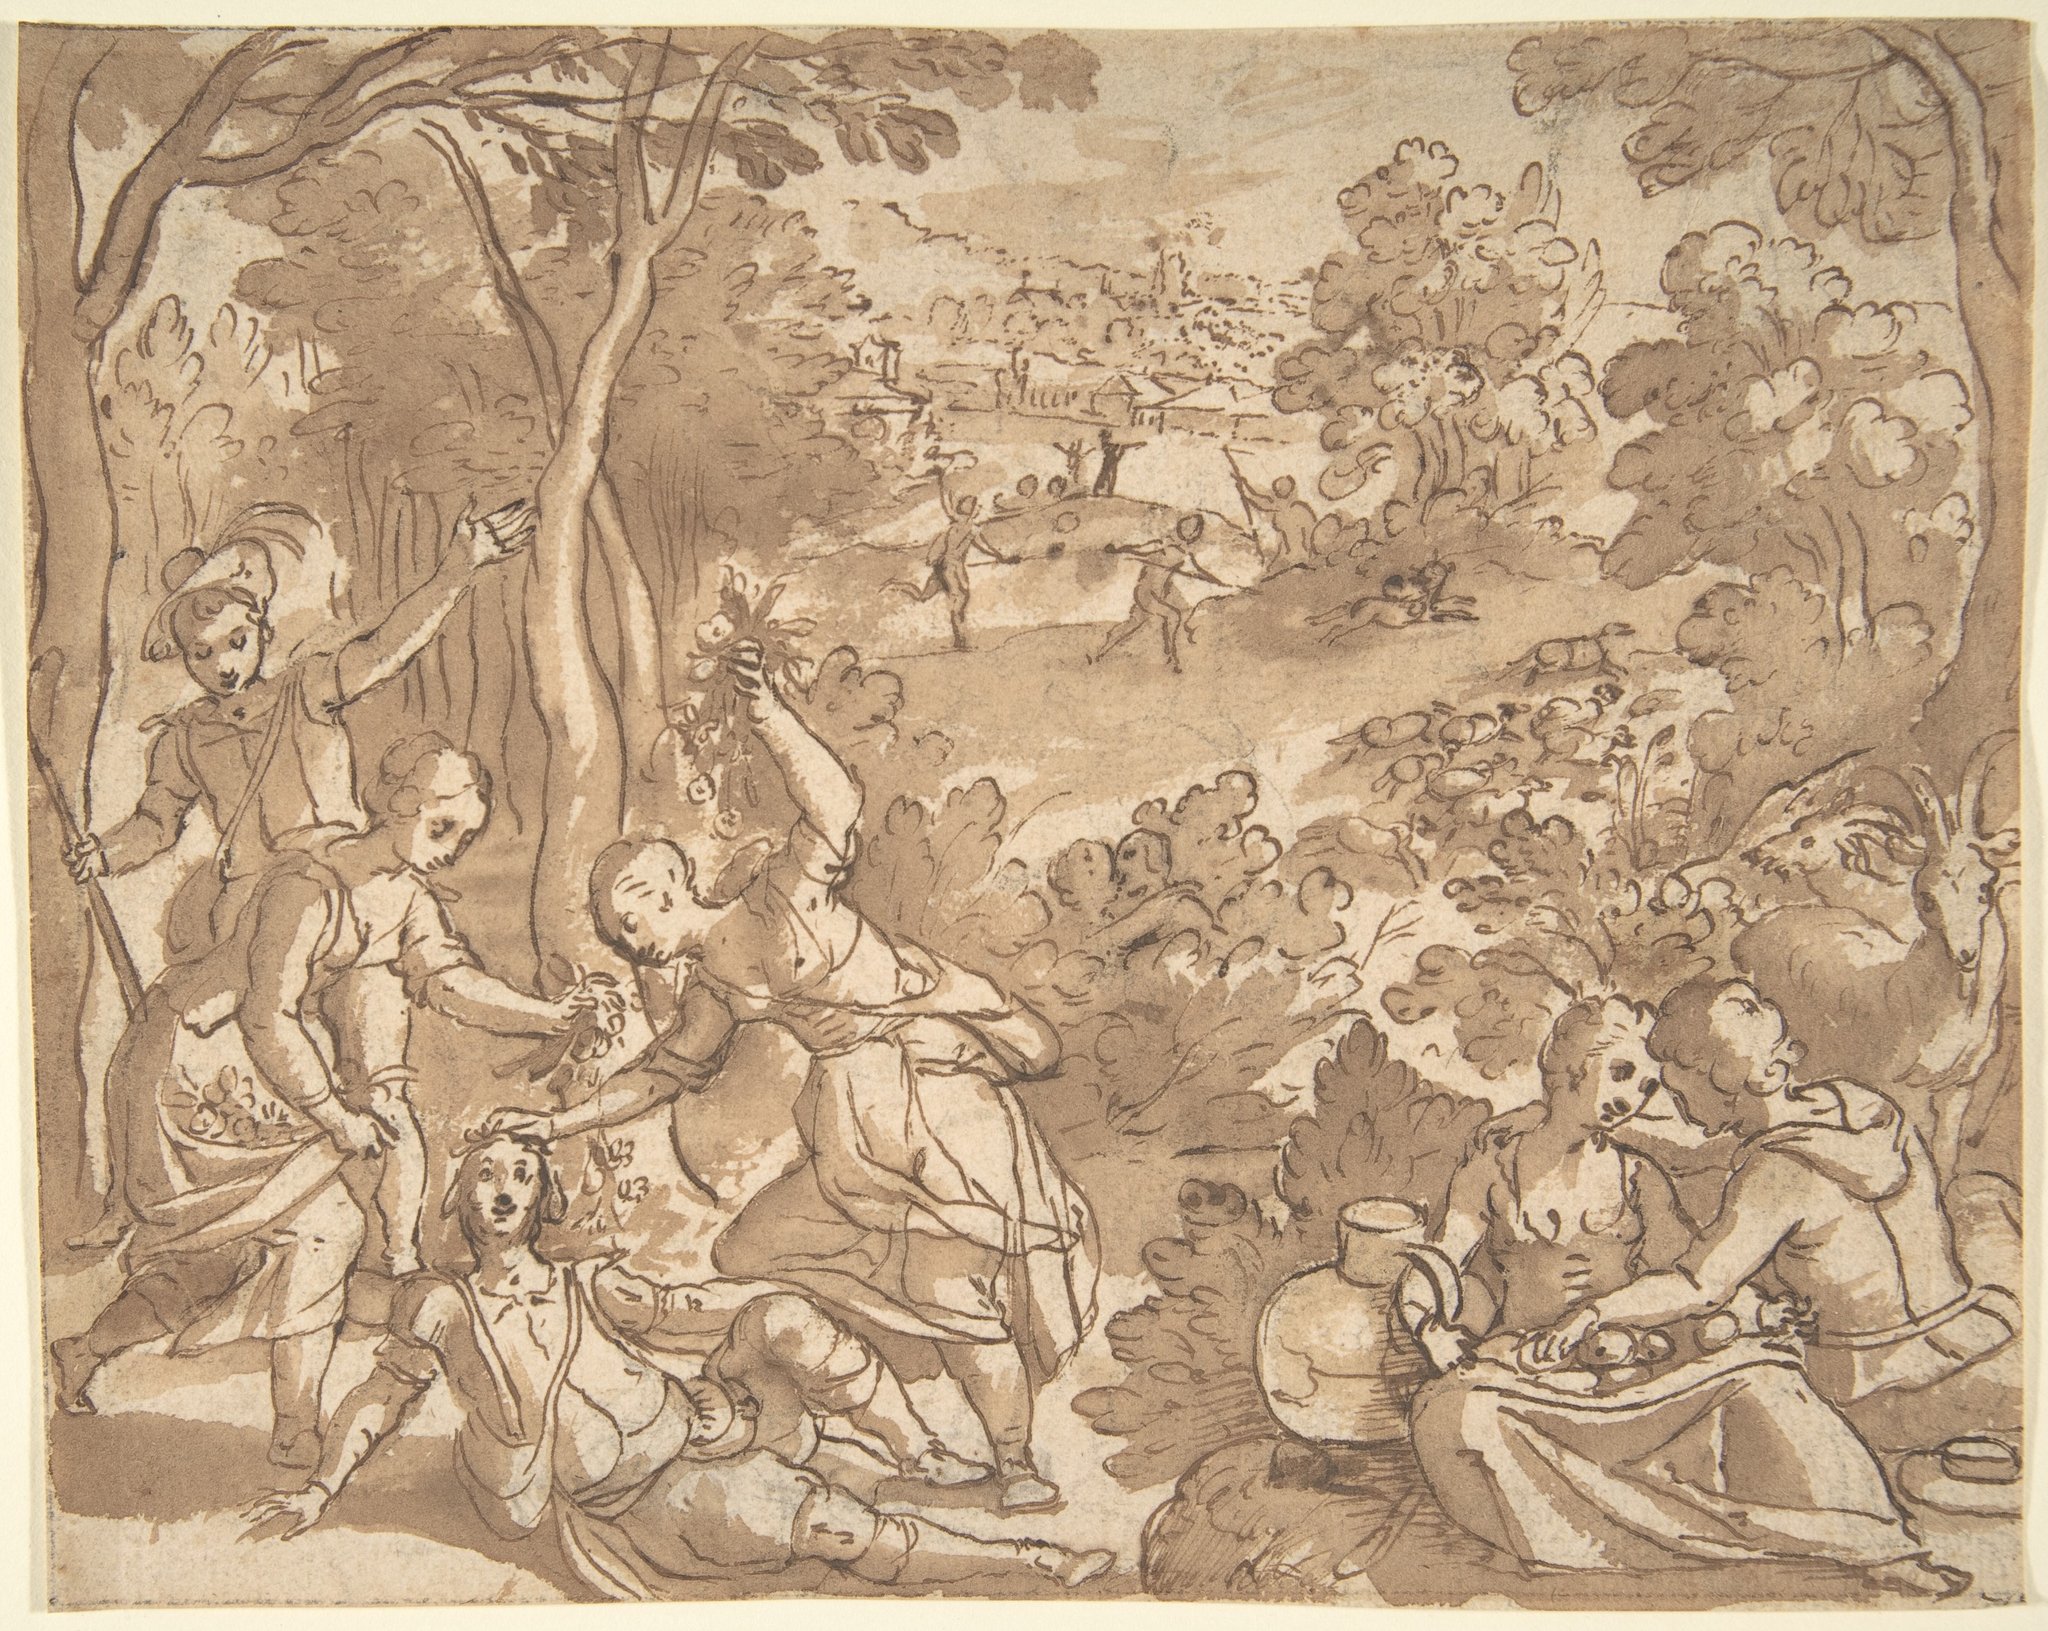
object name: drawing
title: Landscape with Lovers and Hunters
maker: adam van noort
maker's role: artist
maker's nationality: netherlandish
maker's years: 1561-1641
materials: chalk, ink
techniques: pen, wash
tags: men,lovers,women,landscapes